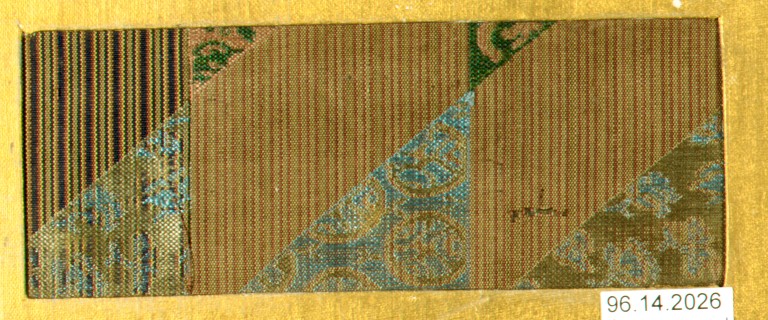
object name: piece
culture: japanese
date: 1701-1900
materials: silk